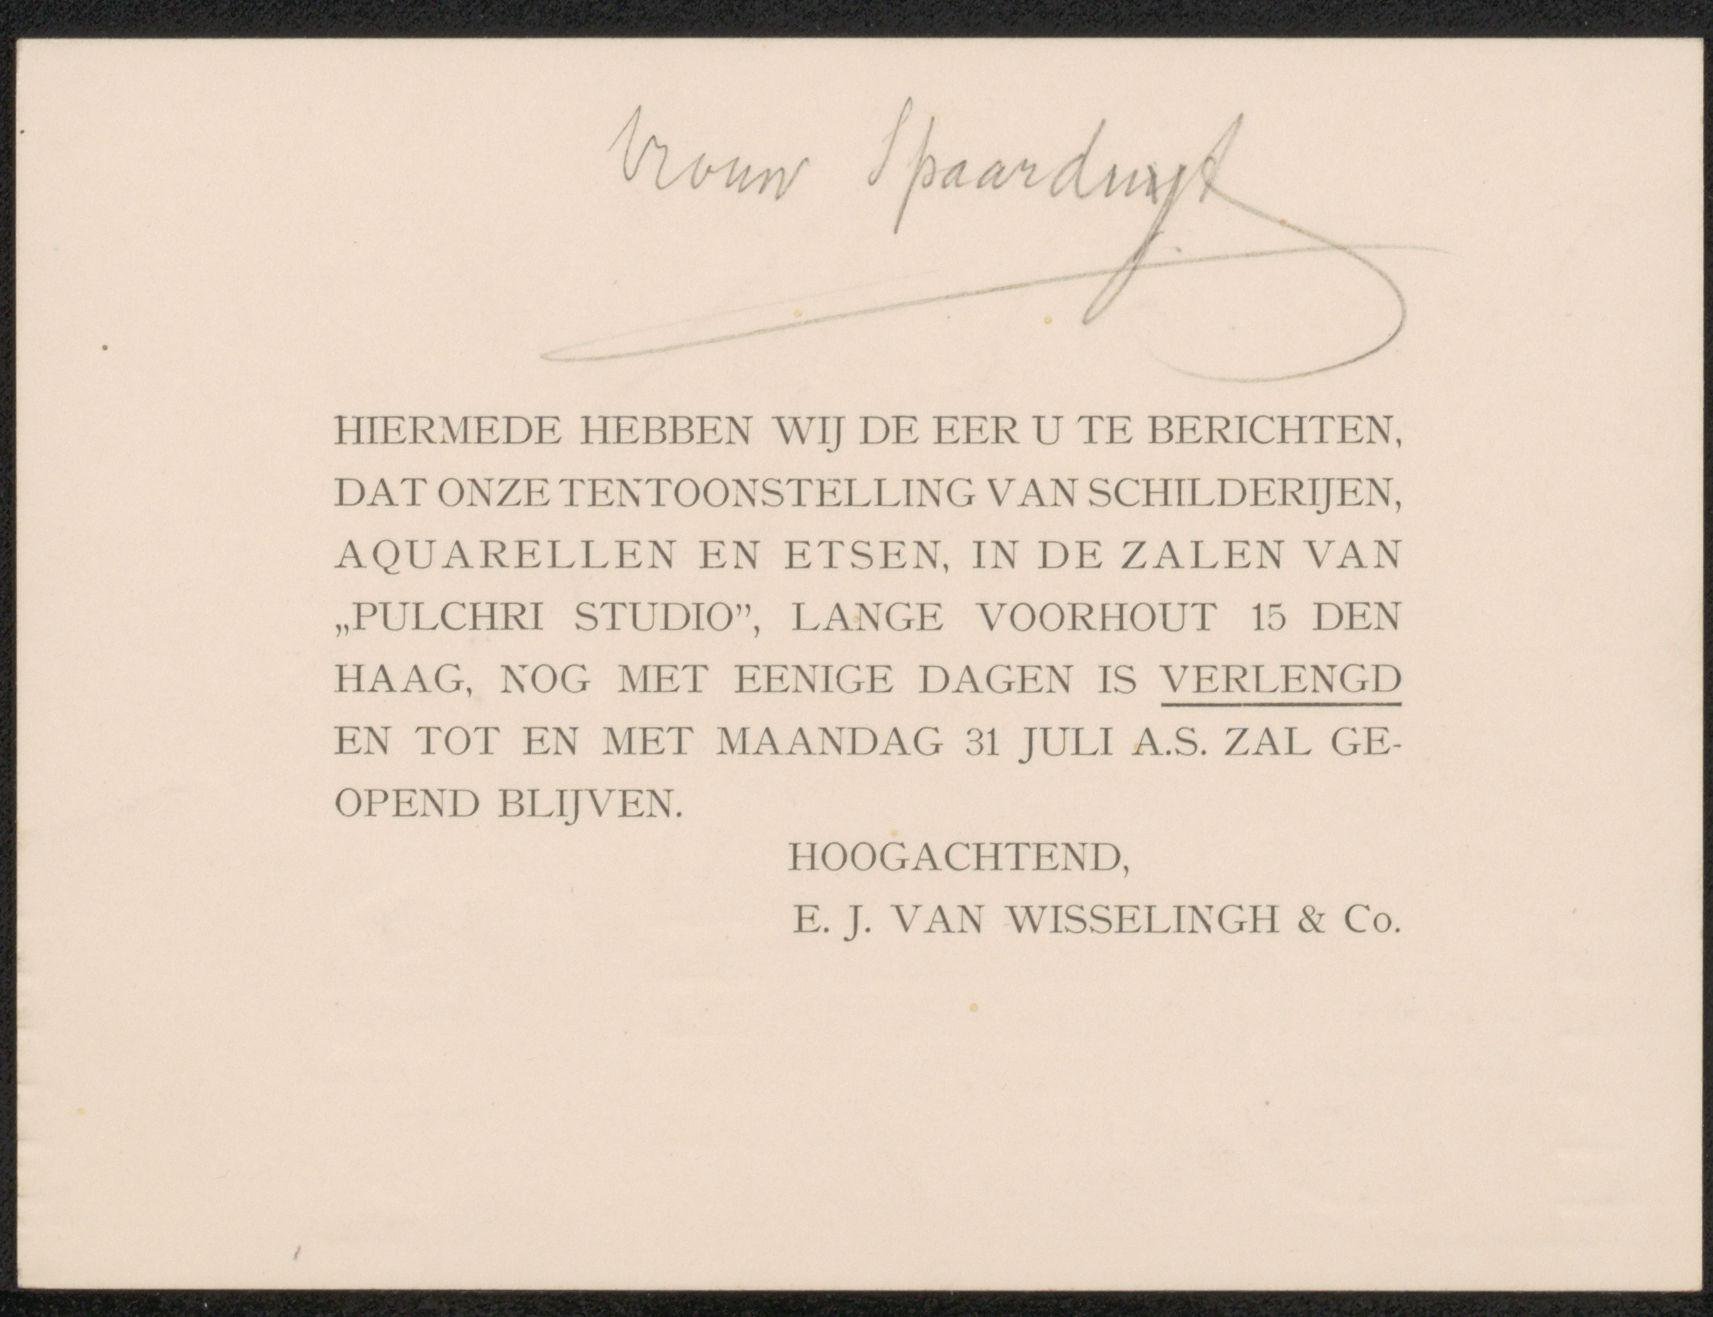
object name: letter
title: Aankondiging betreffende een tentoonstelling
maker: august allebé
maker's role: draughtsman, print maker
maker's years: 1838-1927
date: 1848-1927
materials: cardboard, ink, pencil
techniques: pen, printing, writing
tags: drawing, literature ~ arts, the graphic arts, painting (including book-illumination, miniature-painting), exhibition ~ art, the hague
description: Brief bevat aantekening van August Allebé.